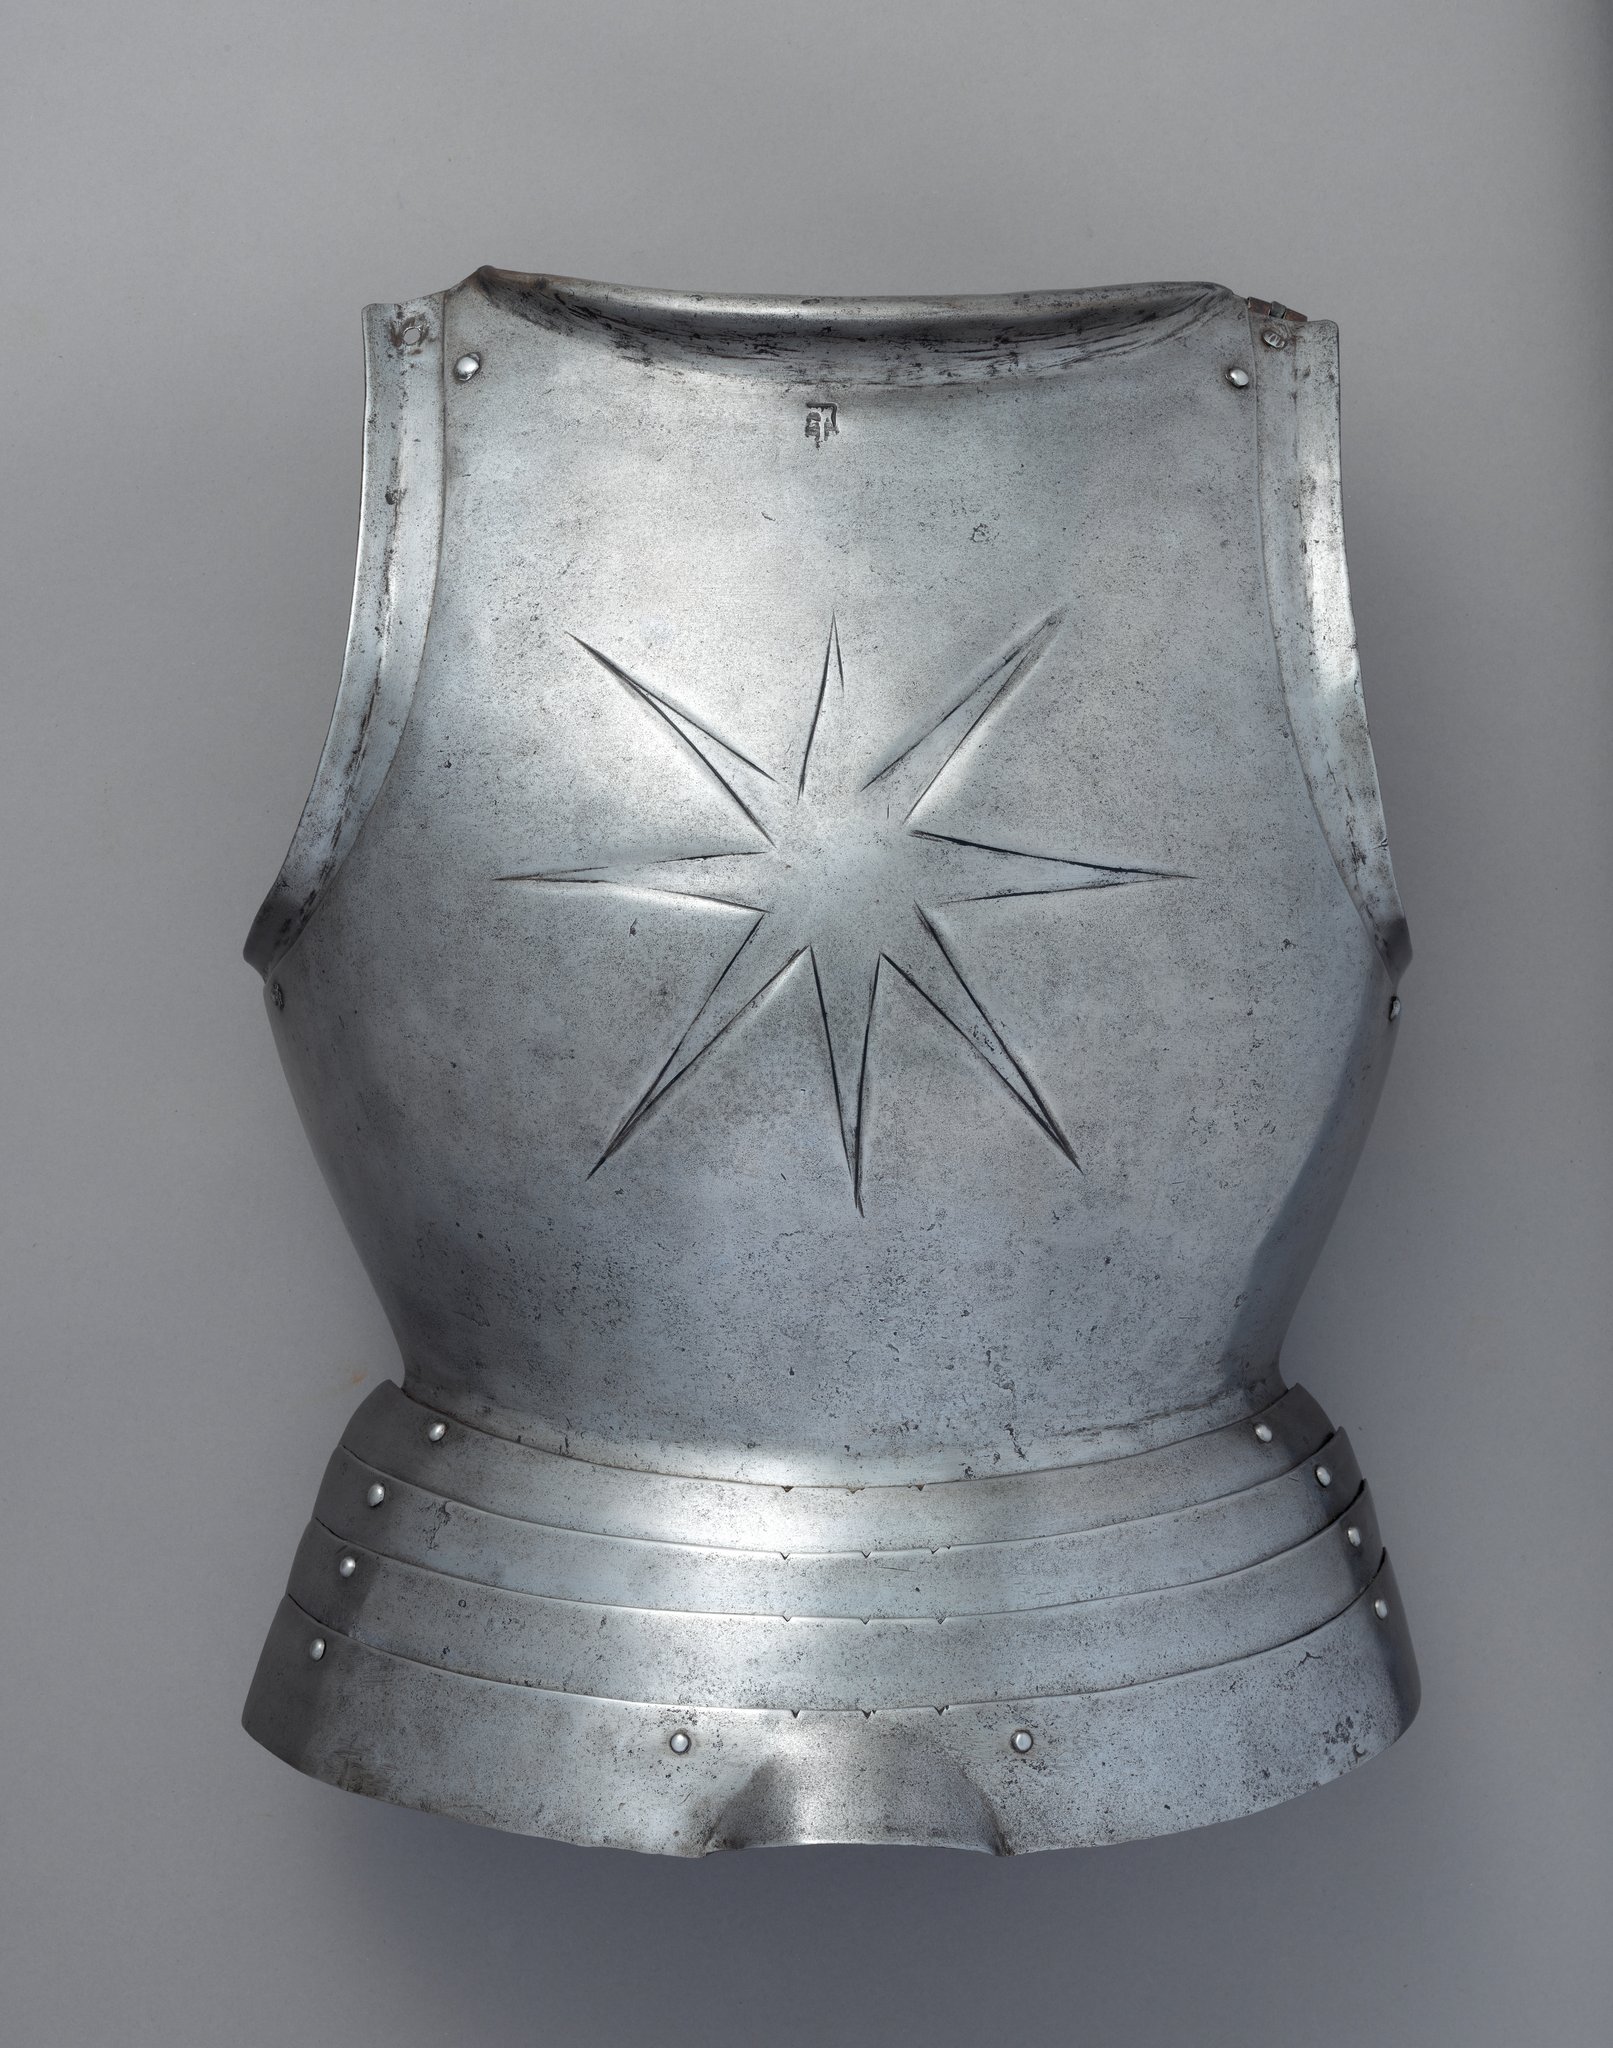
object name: breastplate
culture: german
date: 1500-1510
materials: leather, steel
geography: germany